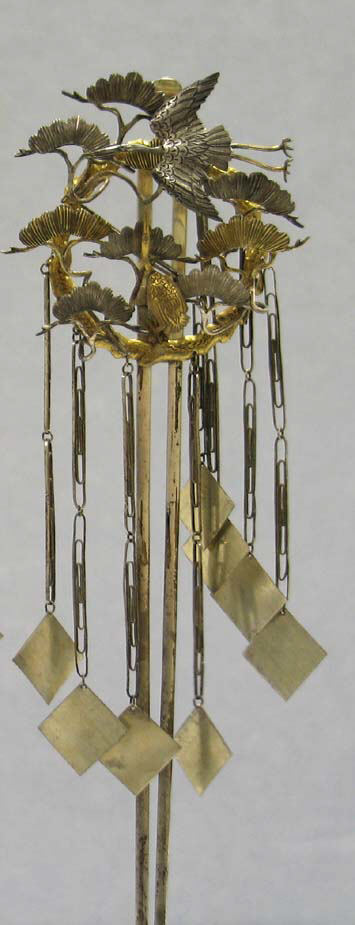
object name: hair ornament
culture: japanese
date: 1867-1900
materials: silver, silver gilt